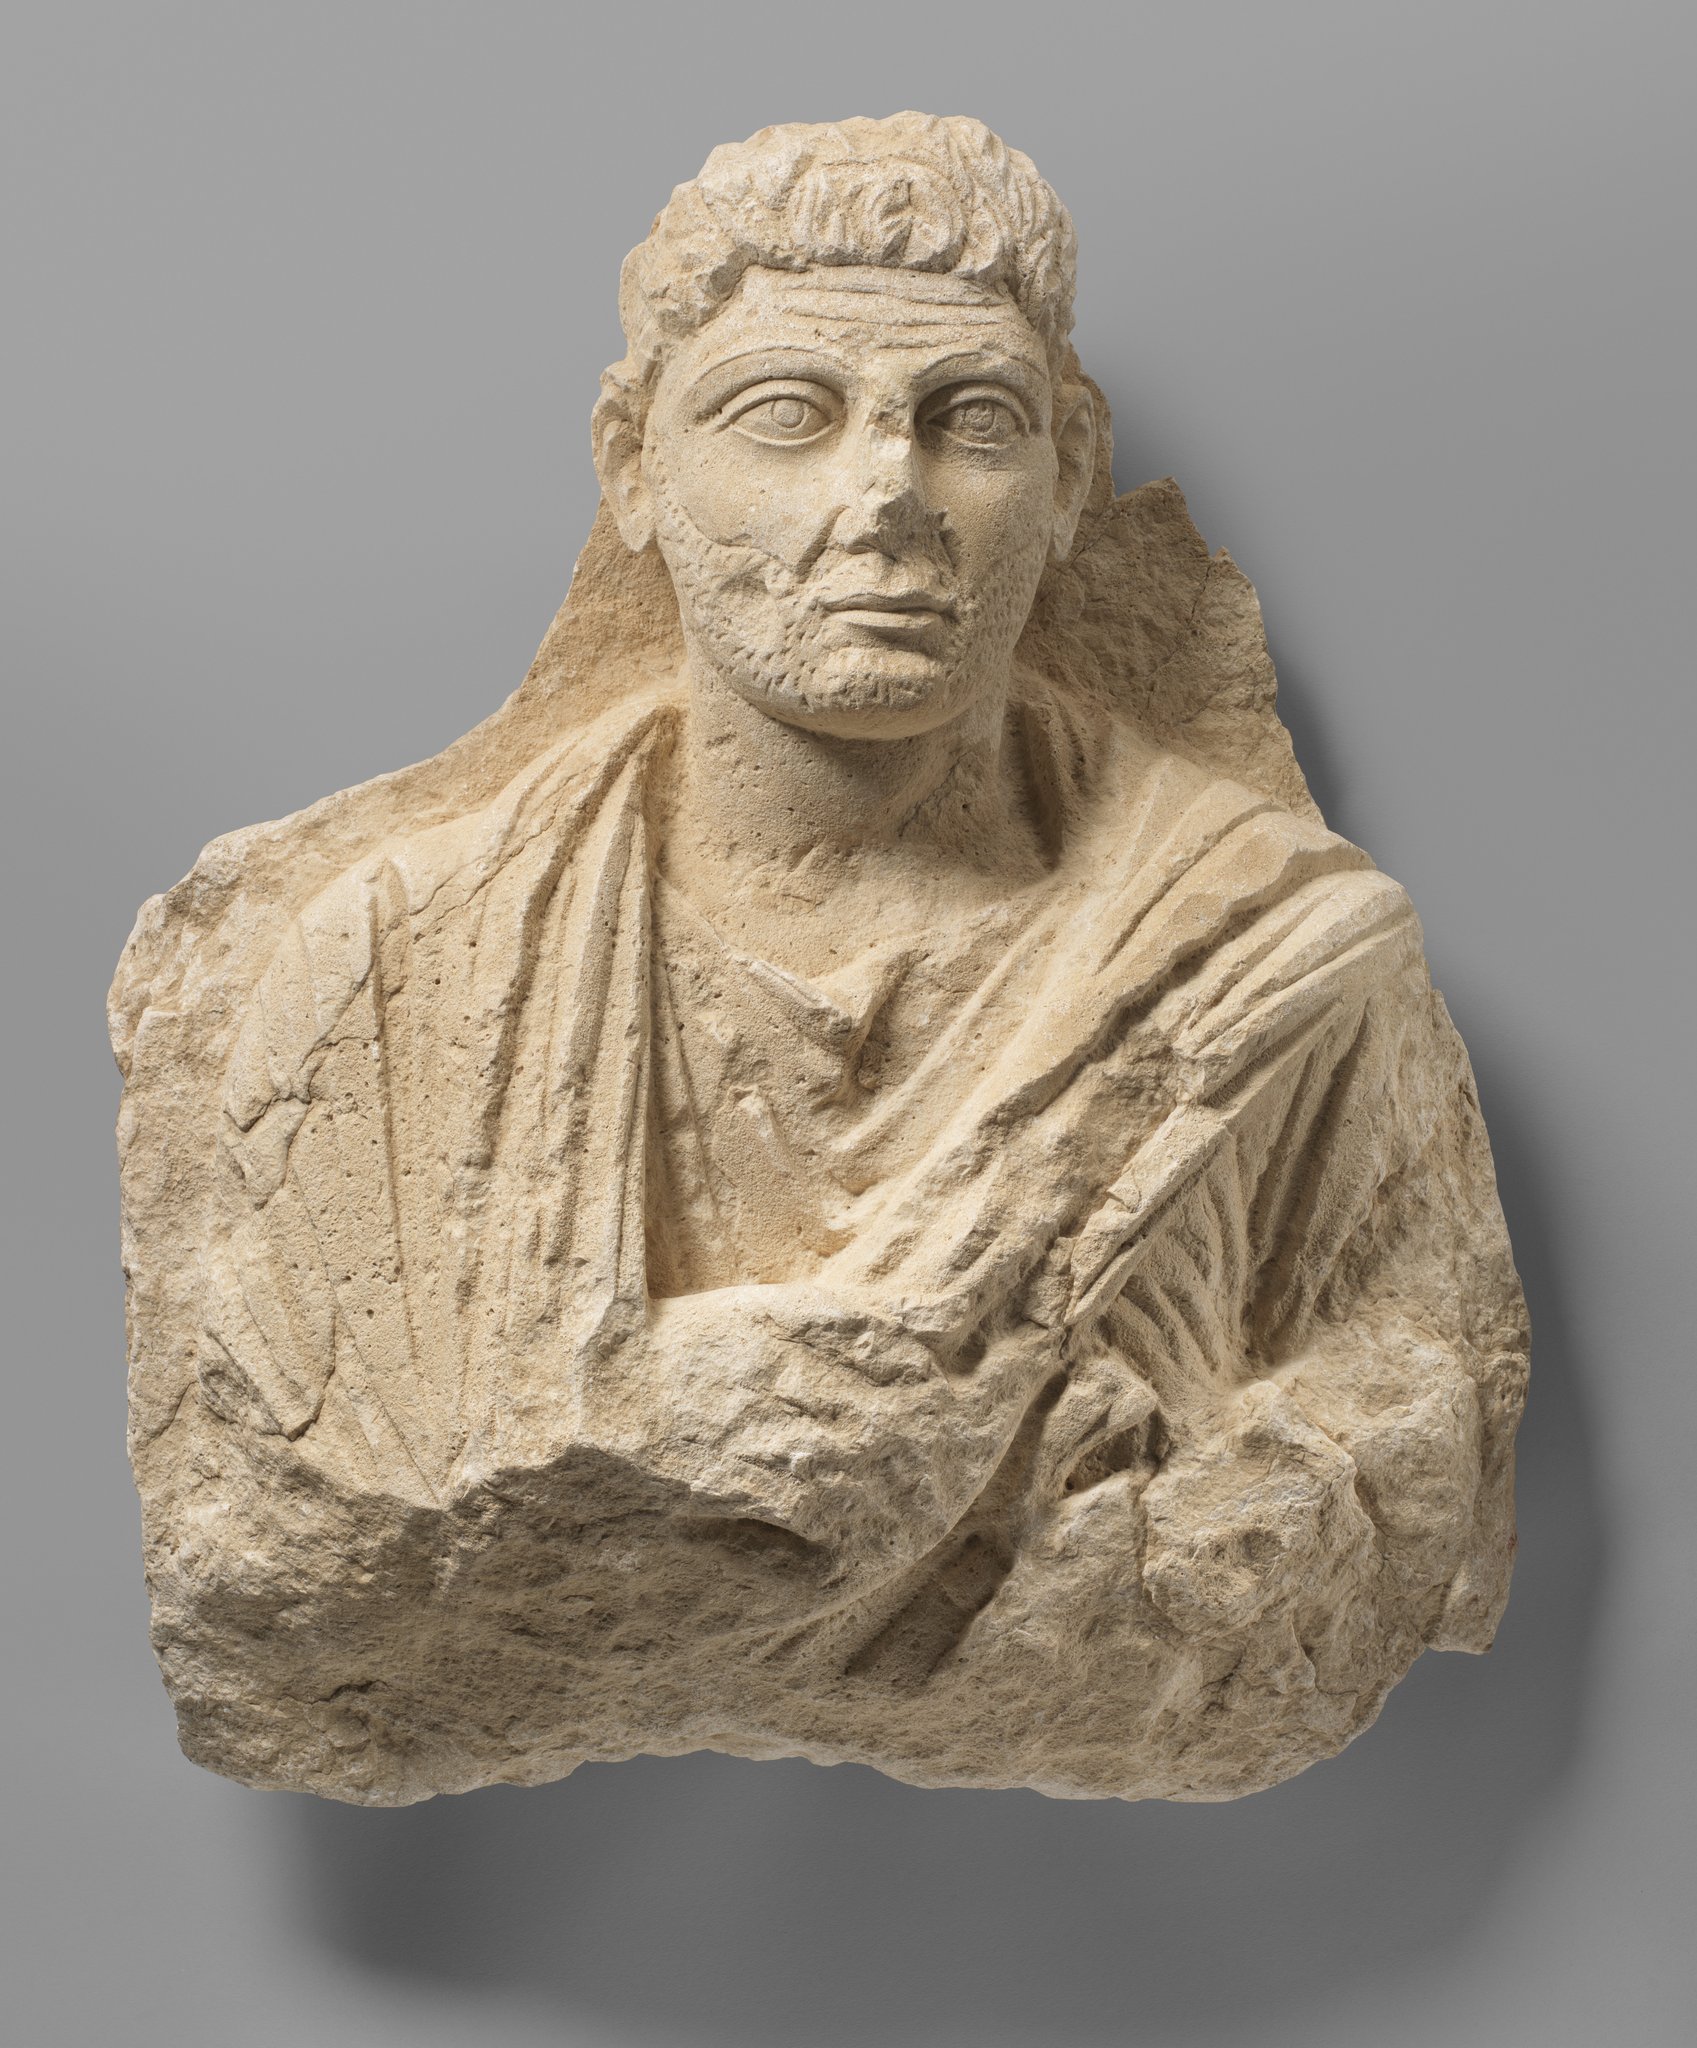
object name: funerary relief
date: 200-273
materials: limestone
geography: syria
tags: men,portraits